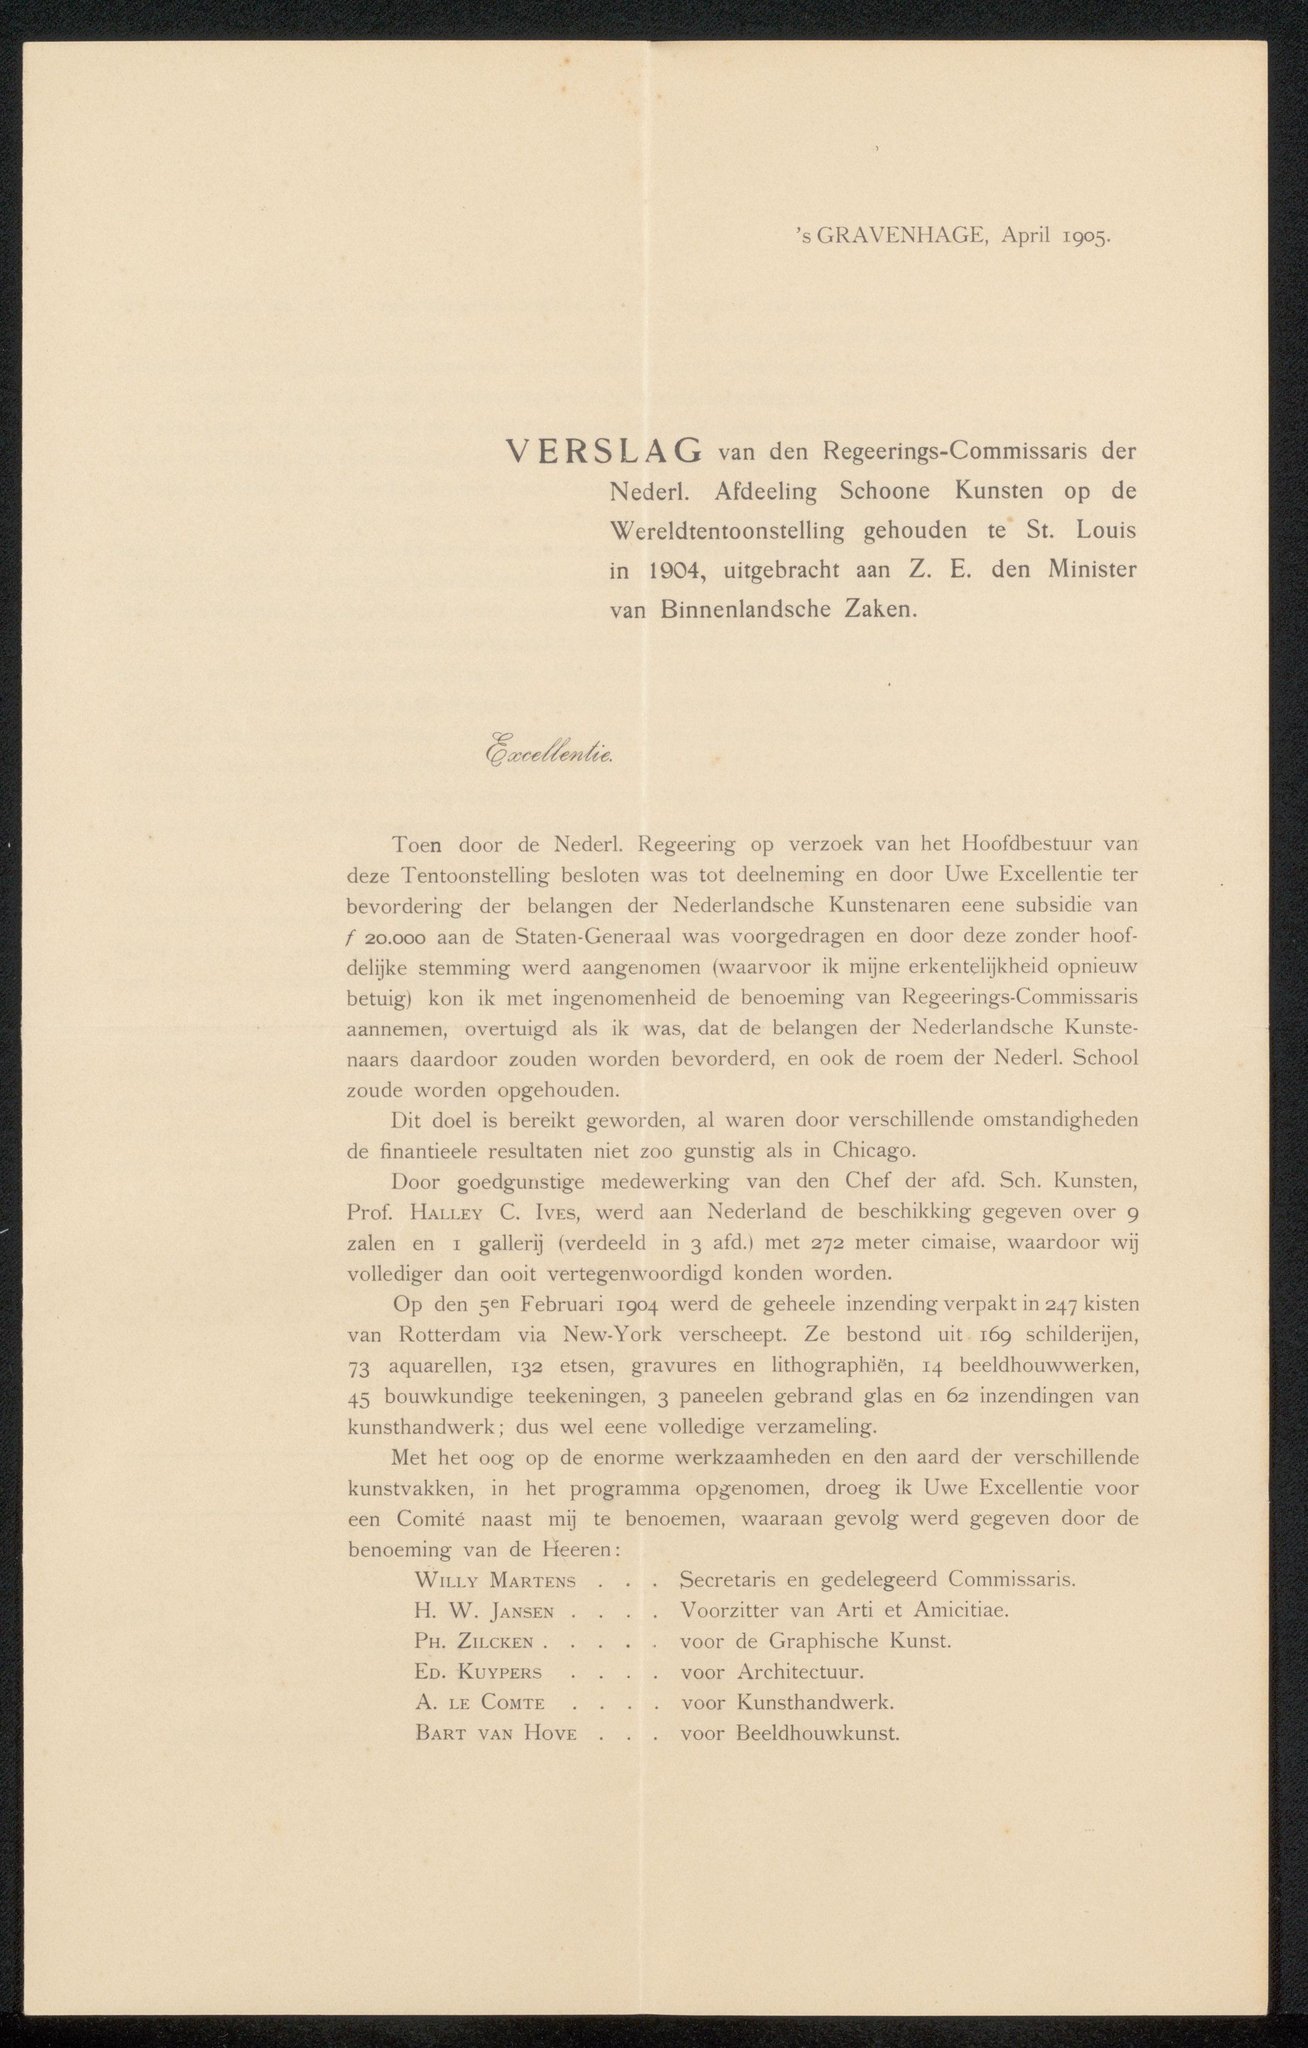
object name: verslag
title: Verslag uit archief Philip Zilcken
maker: hendrik willem mesdag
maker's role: draughtsman, painter, print maker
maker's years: 1831-1915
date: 1904-1905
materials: paper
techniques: printing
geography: the hague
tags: philip zilcken, temporary exhibition, 'salon'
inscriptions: collector's mark: ‘RPK’